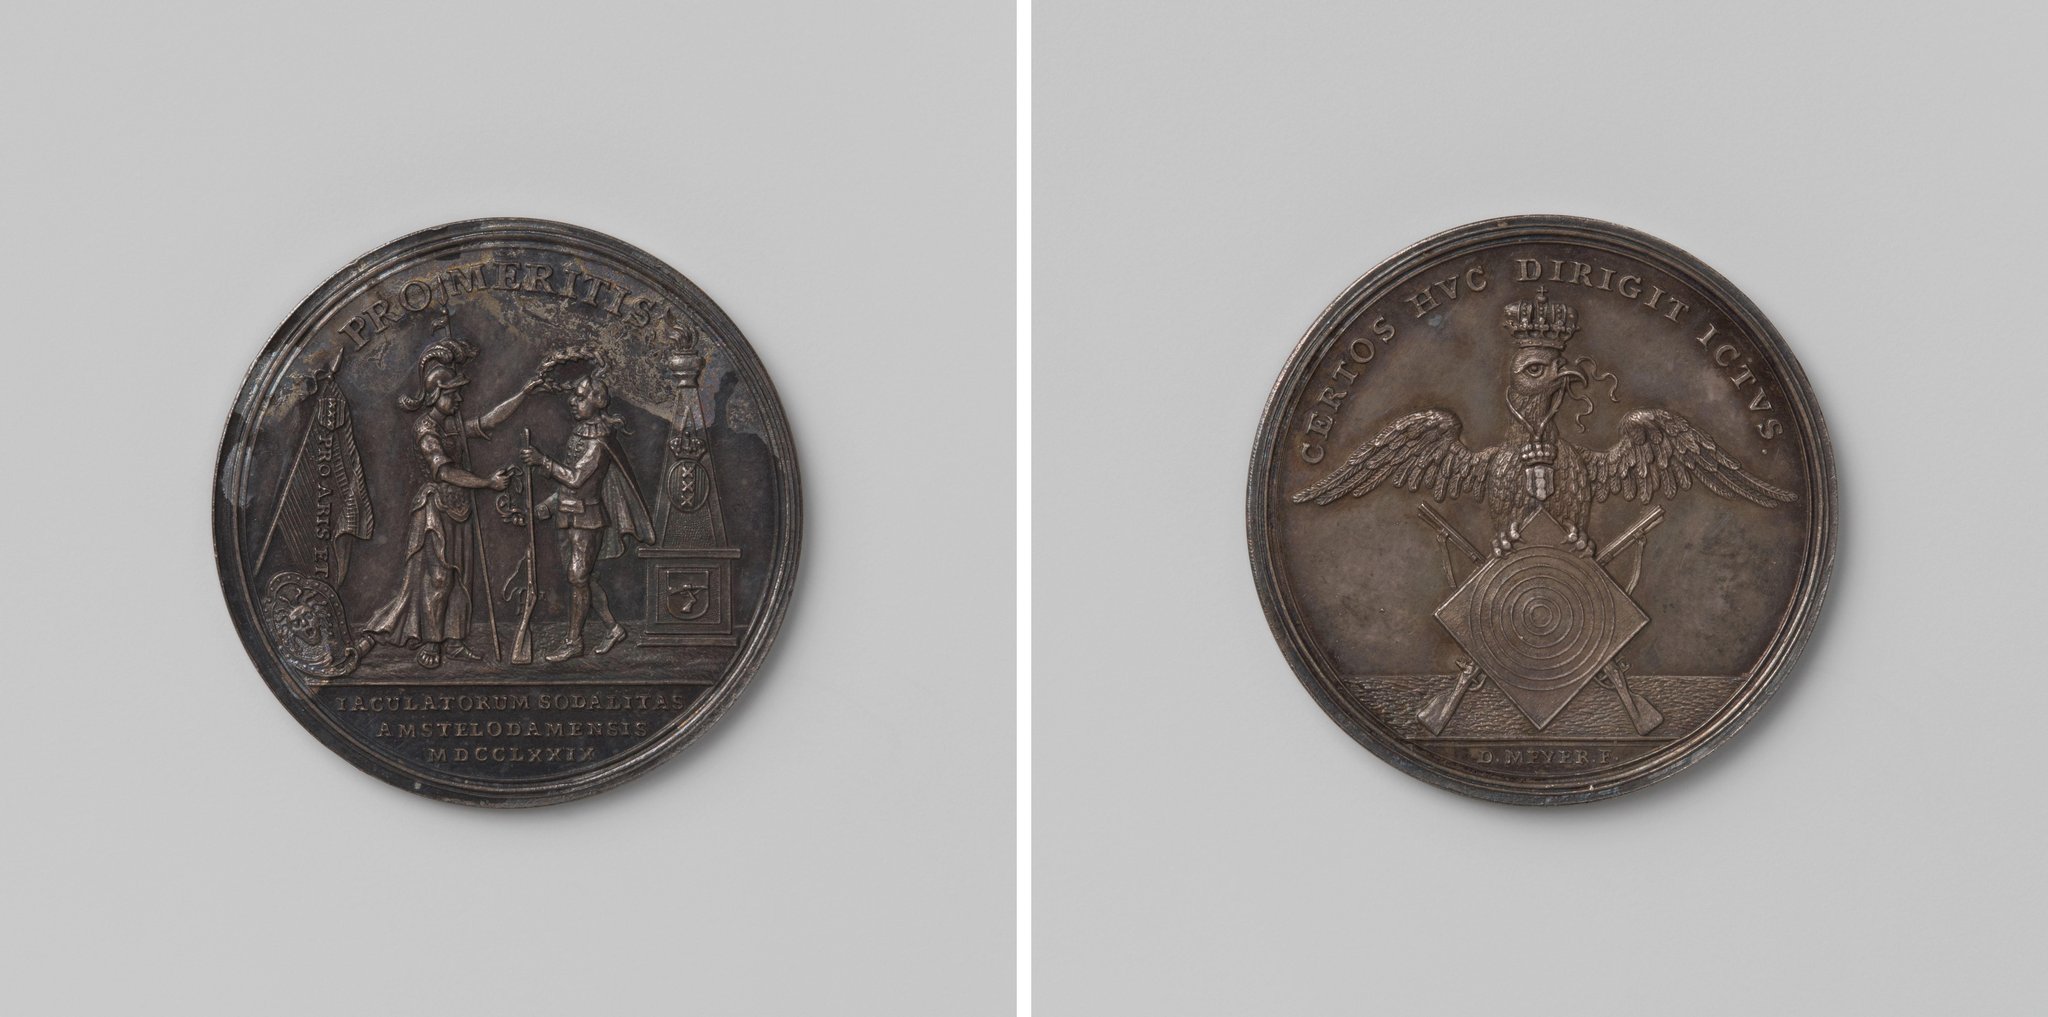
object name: marksman medal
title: Schuttersgezelschap van Amsterdam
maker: hendrik de meijer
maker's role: die cutter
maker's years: 1766-1789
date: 1779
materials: silver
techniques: striking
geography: amsterdam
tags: amsterdam